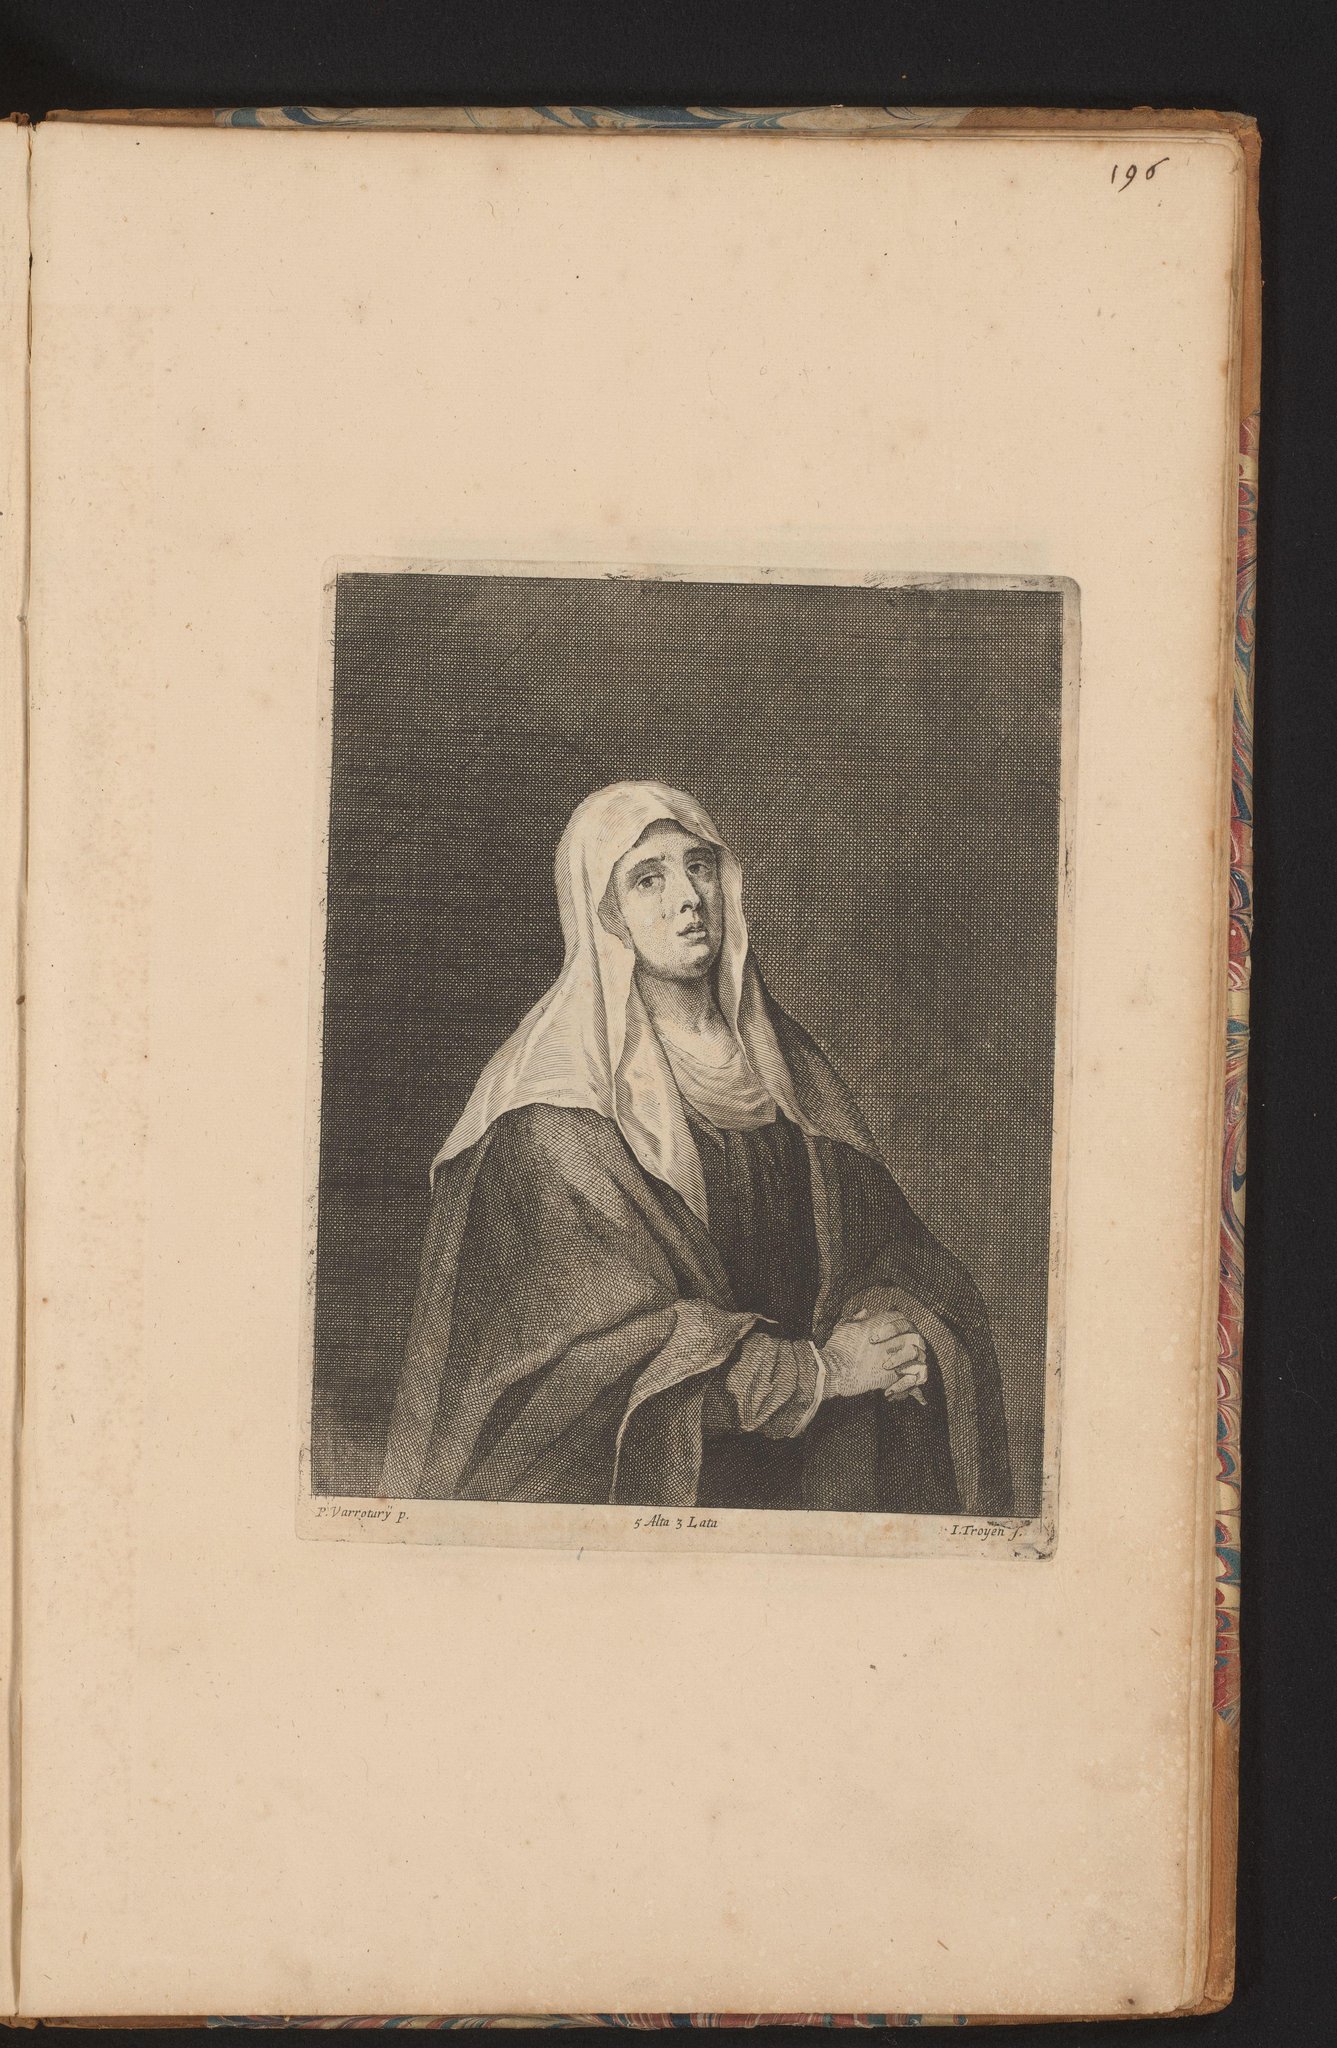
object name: print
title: Rouwende Maria (Mater Dolorosa)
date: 1660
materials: paper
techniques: etching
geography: italy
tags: mary weeping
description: David Teniers heeft waarschijnlijk van alle schilderijen uit de collectie van Leopold Willem van Oostenrijk een olieverfstudie op doek of paneel vervaardigd (zgn. pasticcio), die als voorbeeld voor de prentmakers diende. Het is niet altijd duidelijk of de pasticci door hem zijn gemaakt of door zijn atelier. Niet alle pasticci zijn overgeleverd.